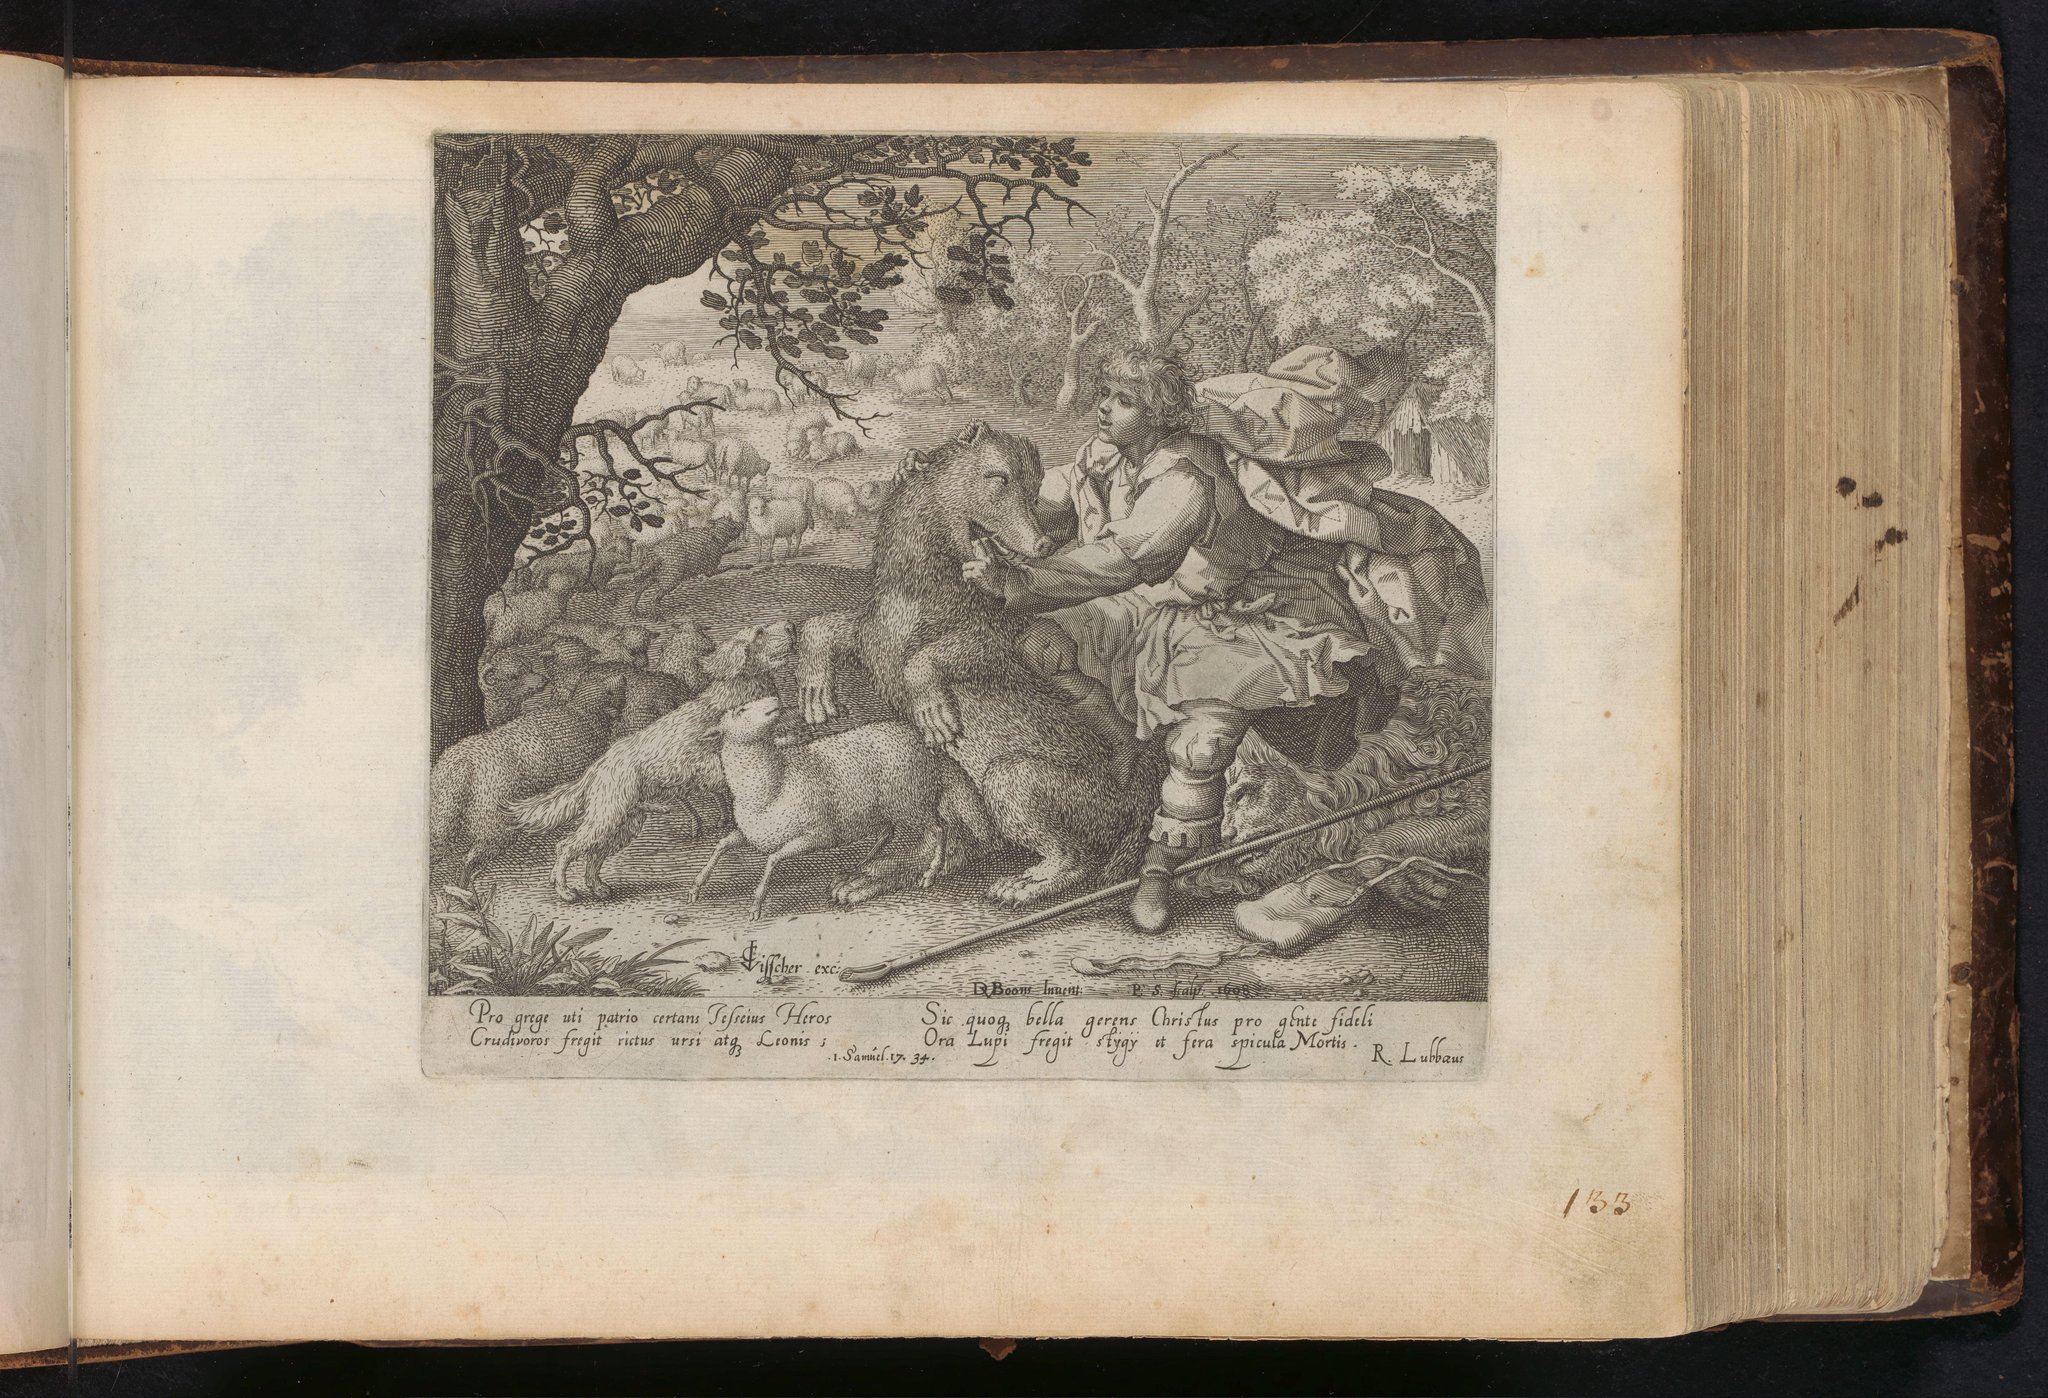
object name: album leaf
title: Den Grooten Figuer-Bibel (...)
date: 1608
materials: paper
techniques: engraving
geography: amsterdam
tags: david kills a lion and a bear (or tells saul about it)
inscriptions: number: ‘133’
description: David grijpt met zijn blote handen een beer, die zijn kudde aanvalt. Aan zijn voeten ligt een gedode leeuw. Onder de voorstelling een verwijzing in het Latijn naar de Bijbeltekst in 1 Sam. 17:34. Deze prent maakt deel uit van een album.